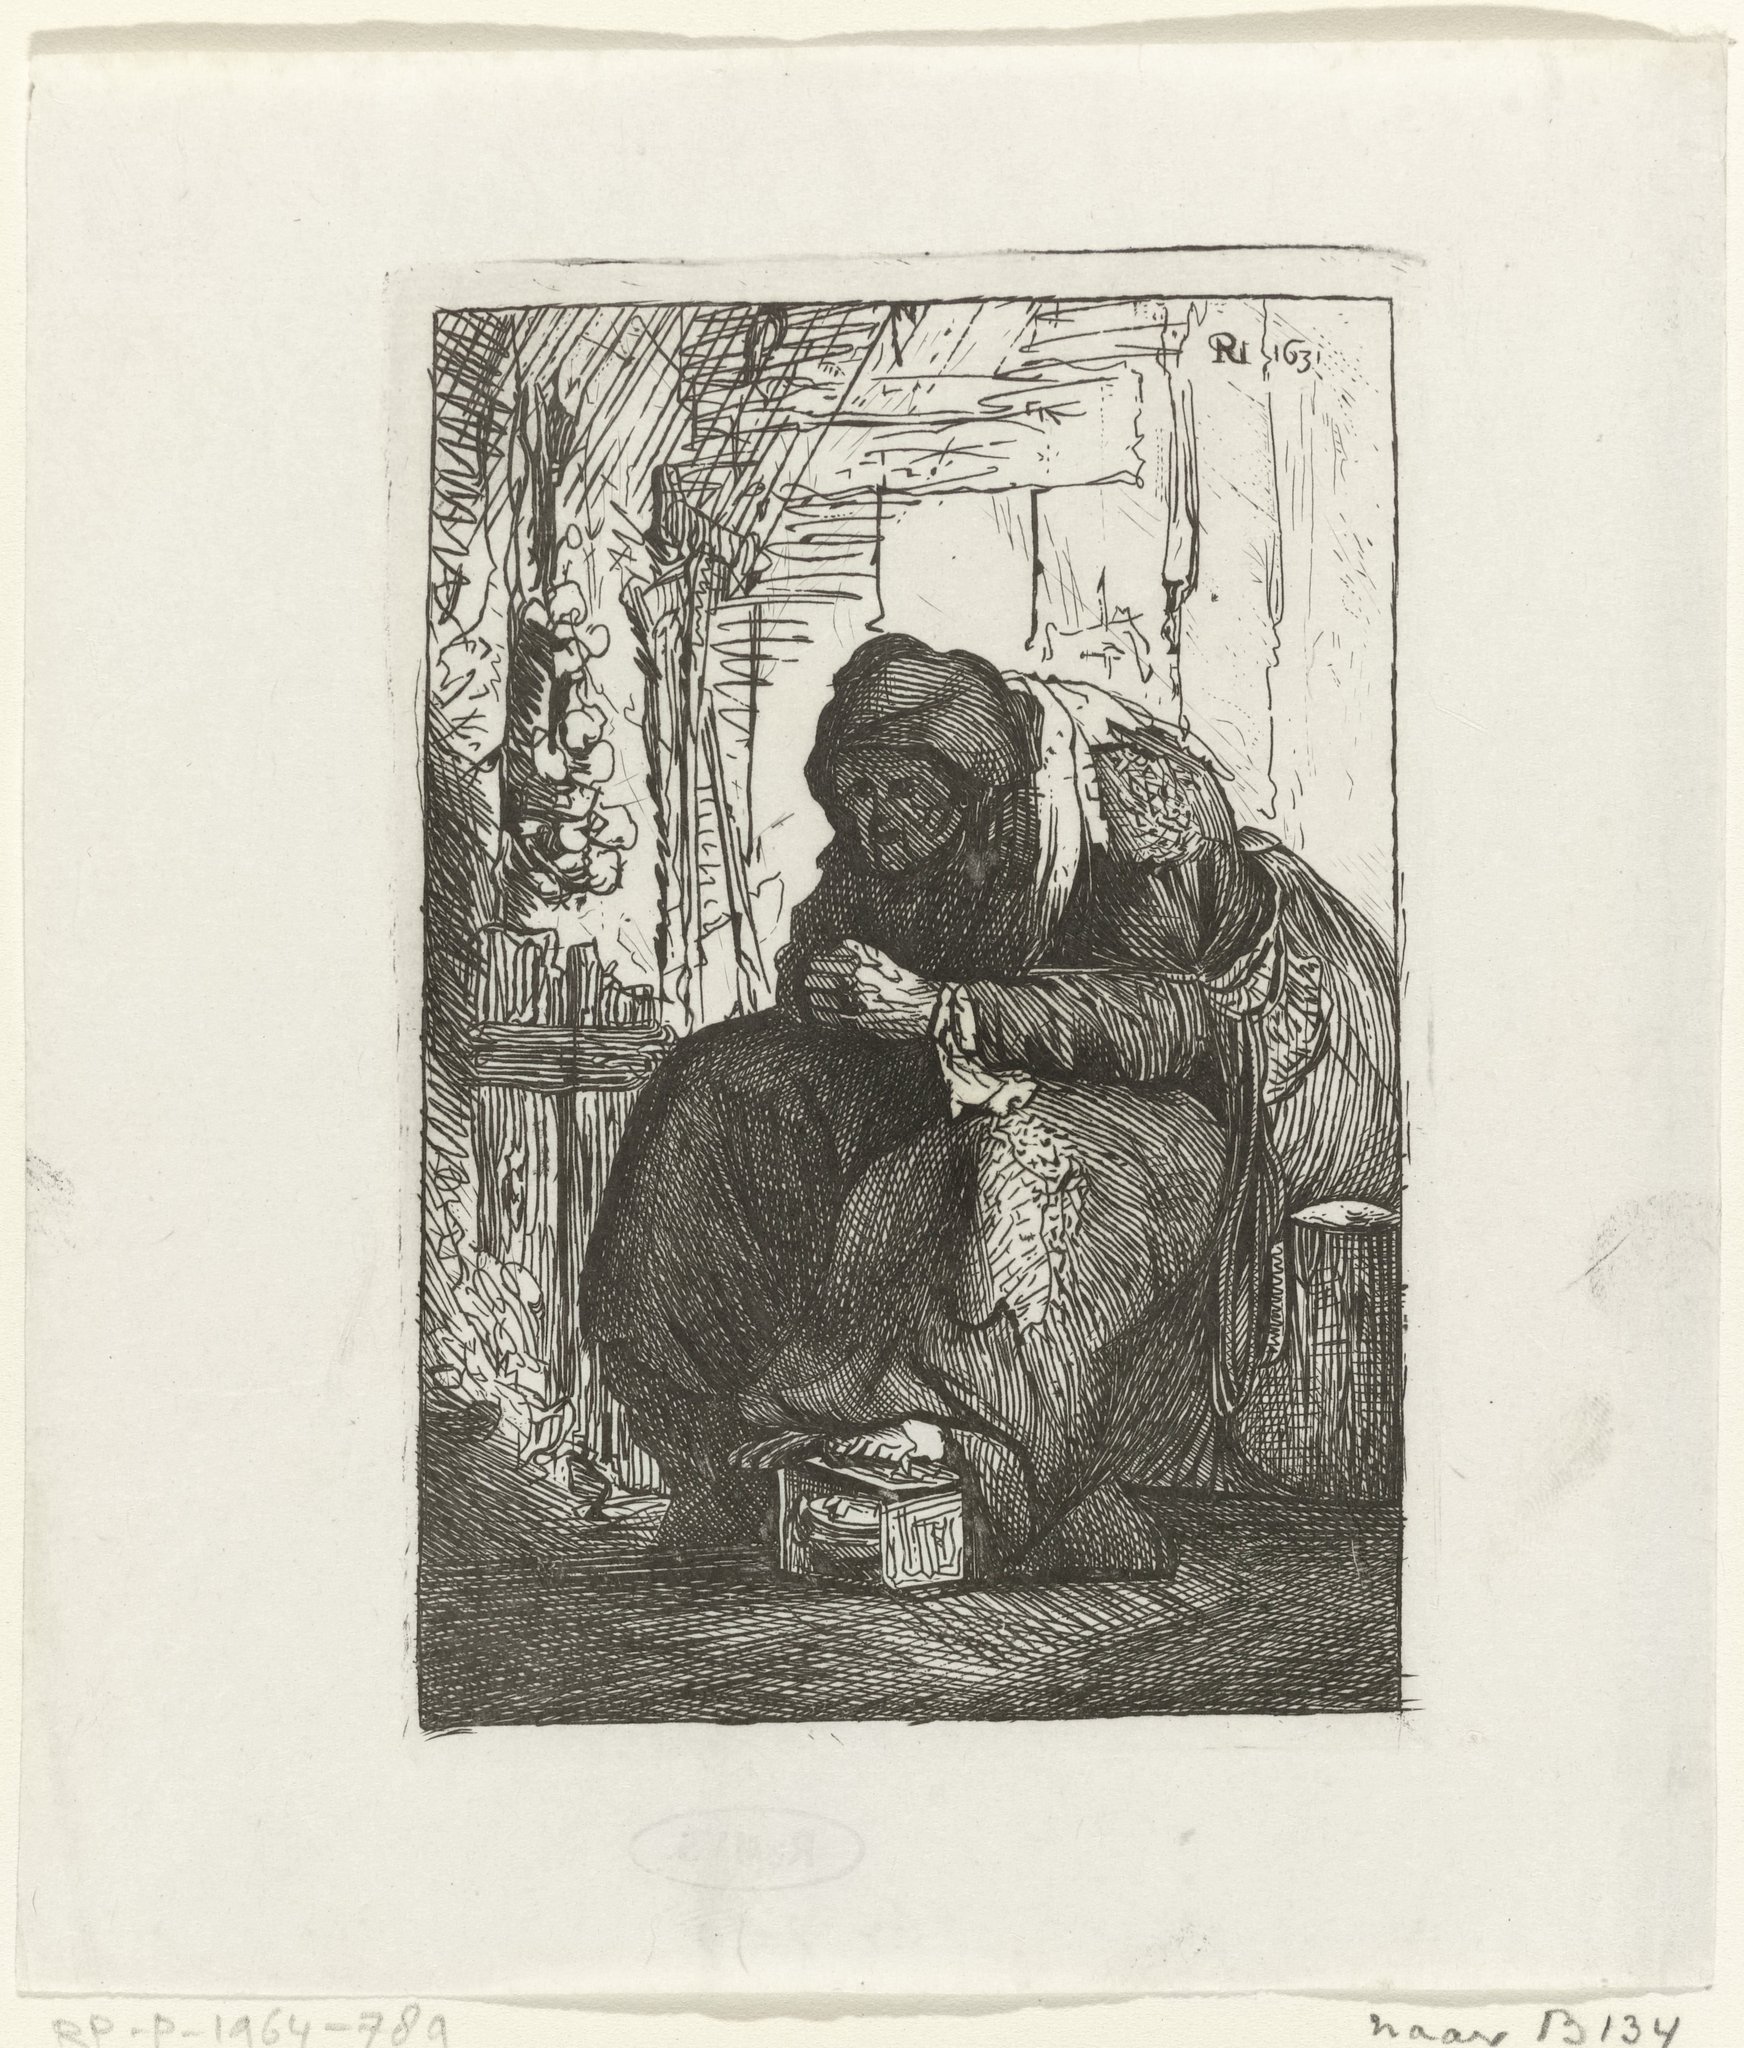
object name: print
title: Twelve Facsimile Etchings from very rare Originals by Rembrandt van Ryn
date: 1824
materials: paper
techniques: etching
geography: london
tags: old woman, (non-fruit) products of plants or trees: onion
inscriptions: collector's mark: Lugt 2228